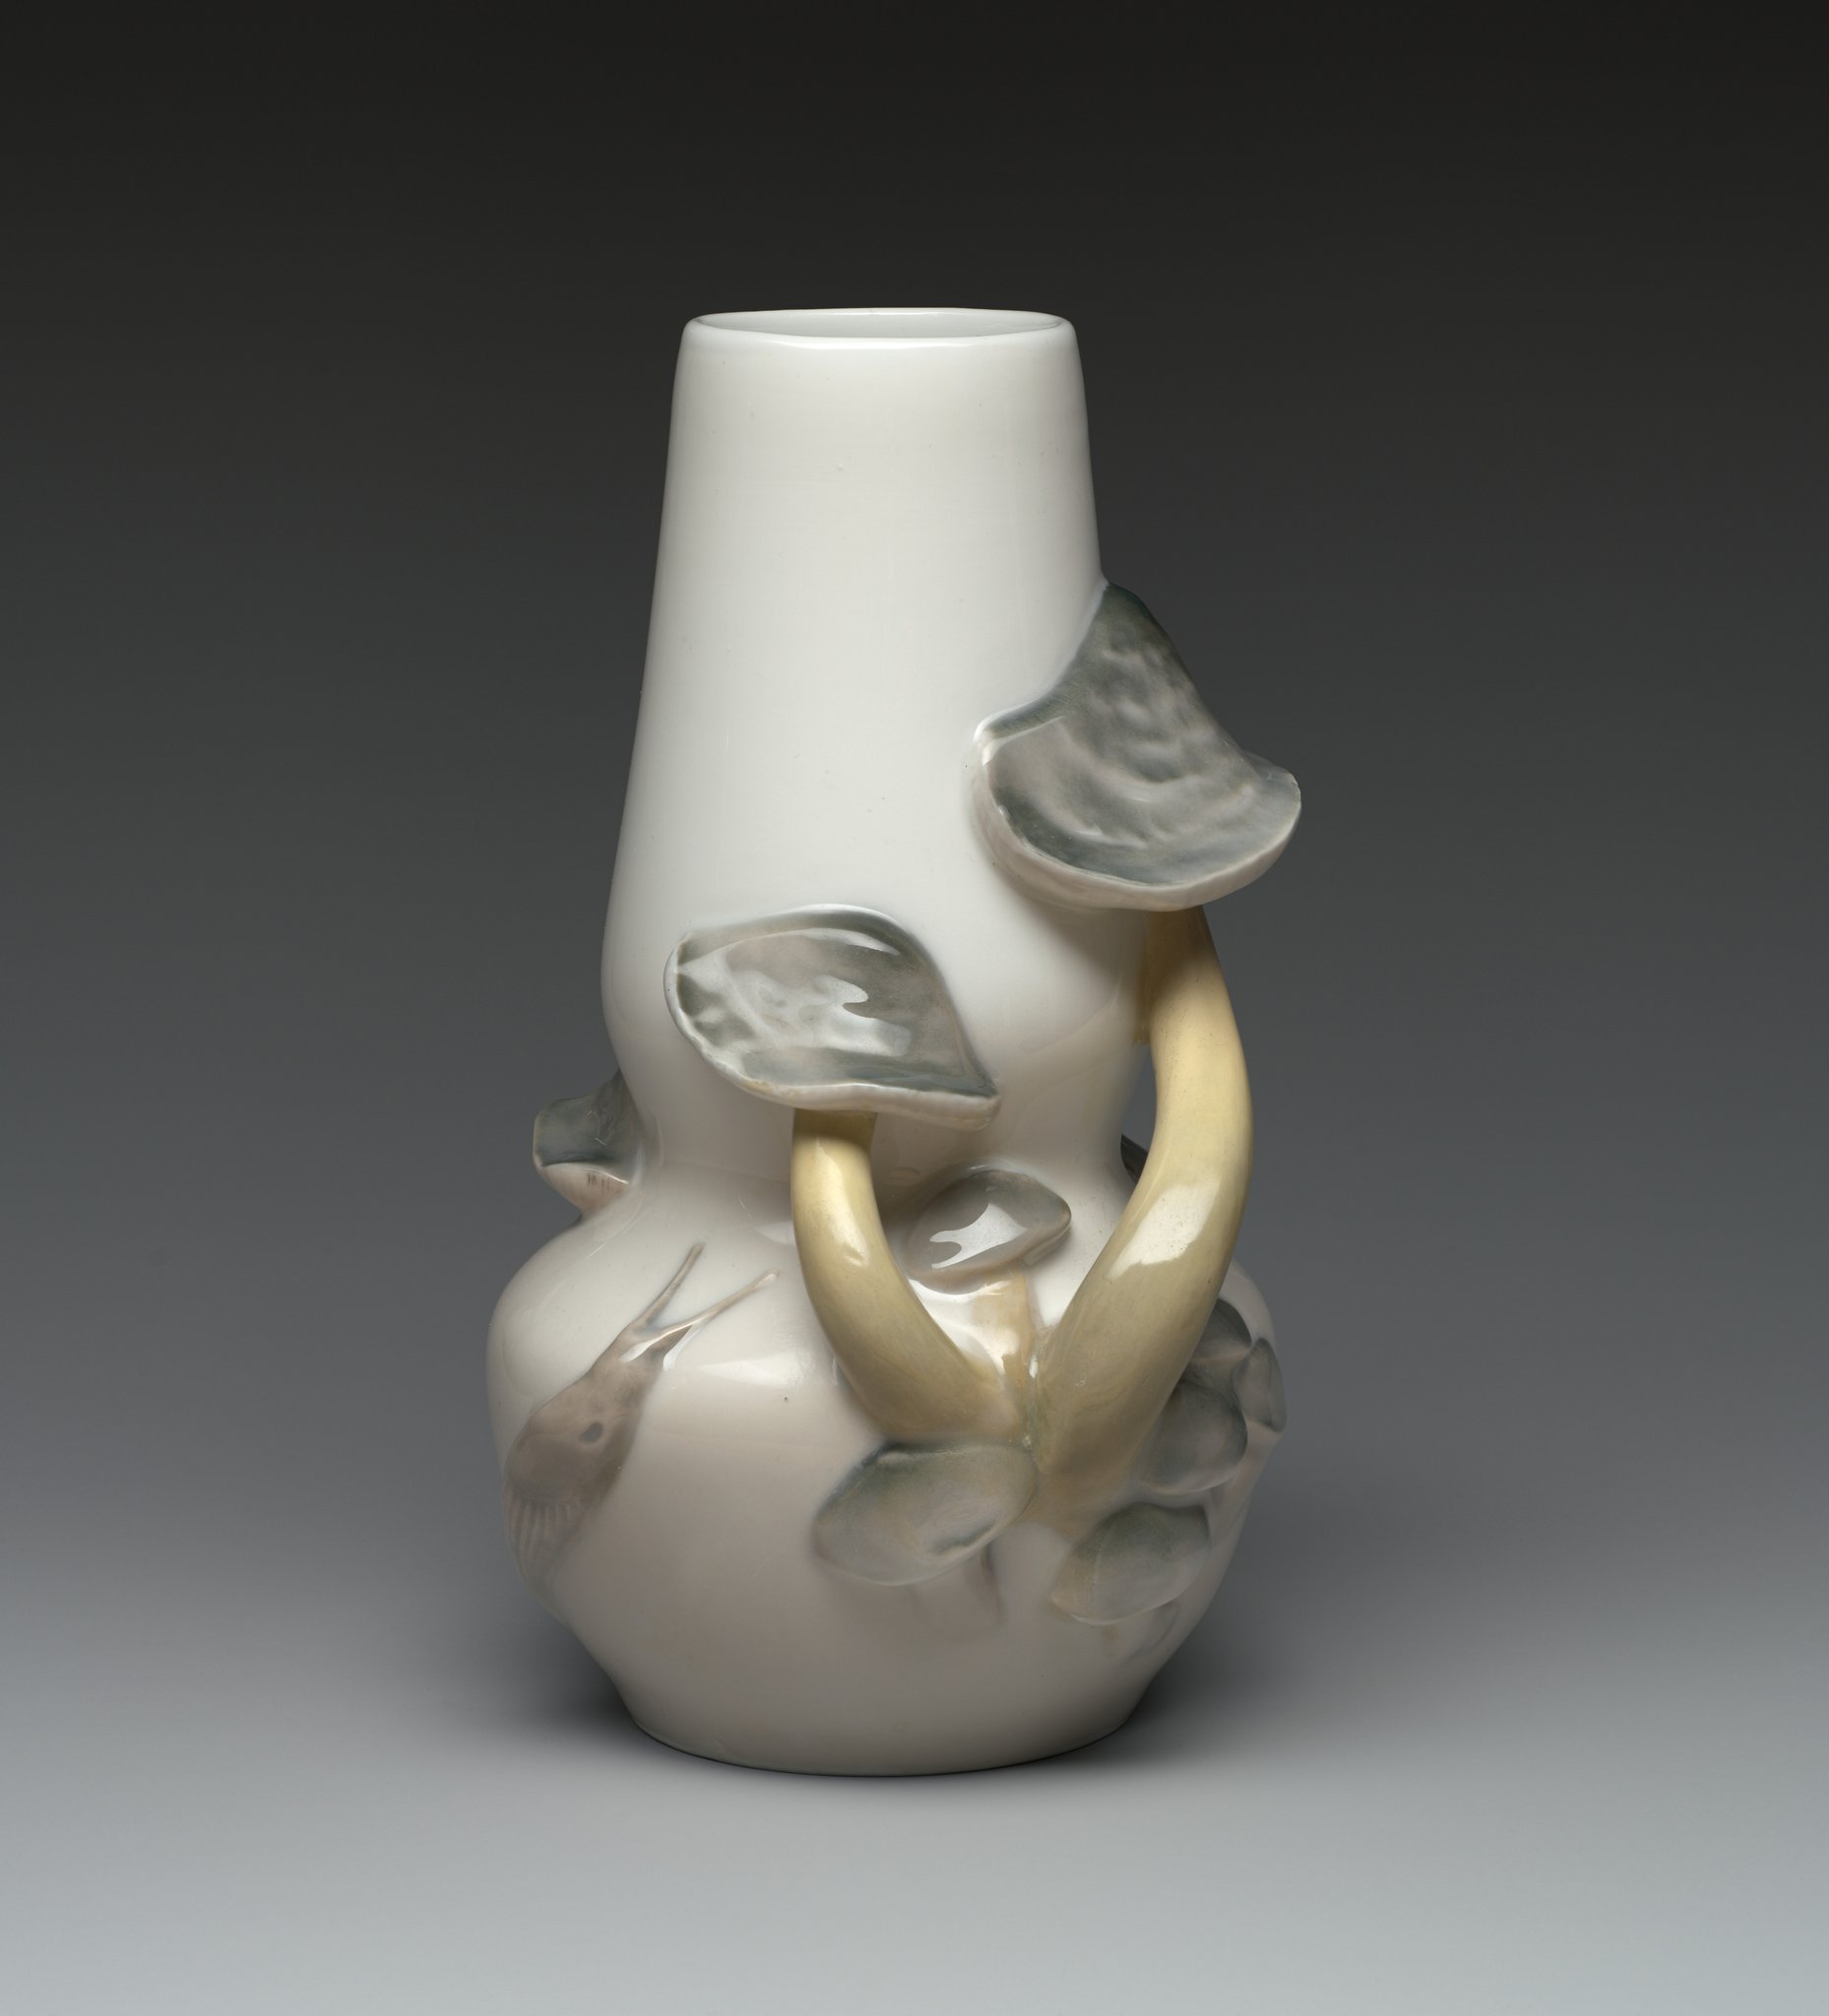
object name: vase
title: Vase with mushrooms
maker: royal copenhagen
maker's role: manufactory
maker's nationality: danish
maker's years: 1775-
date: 1900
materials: porcelain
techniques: glazing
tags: mushrooms